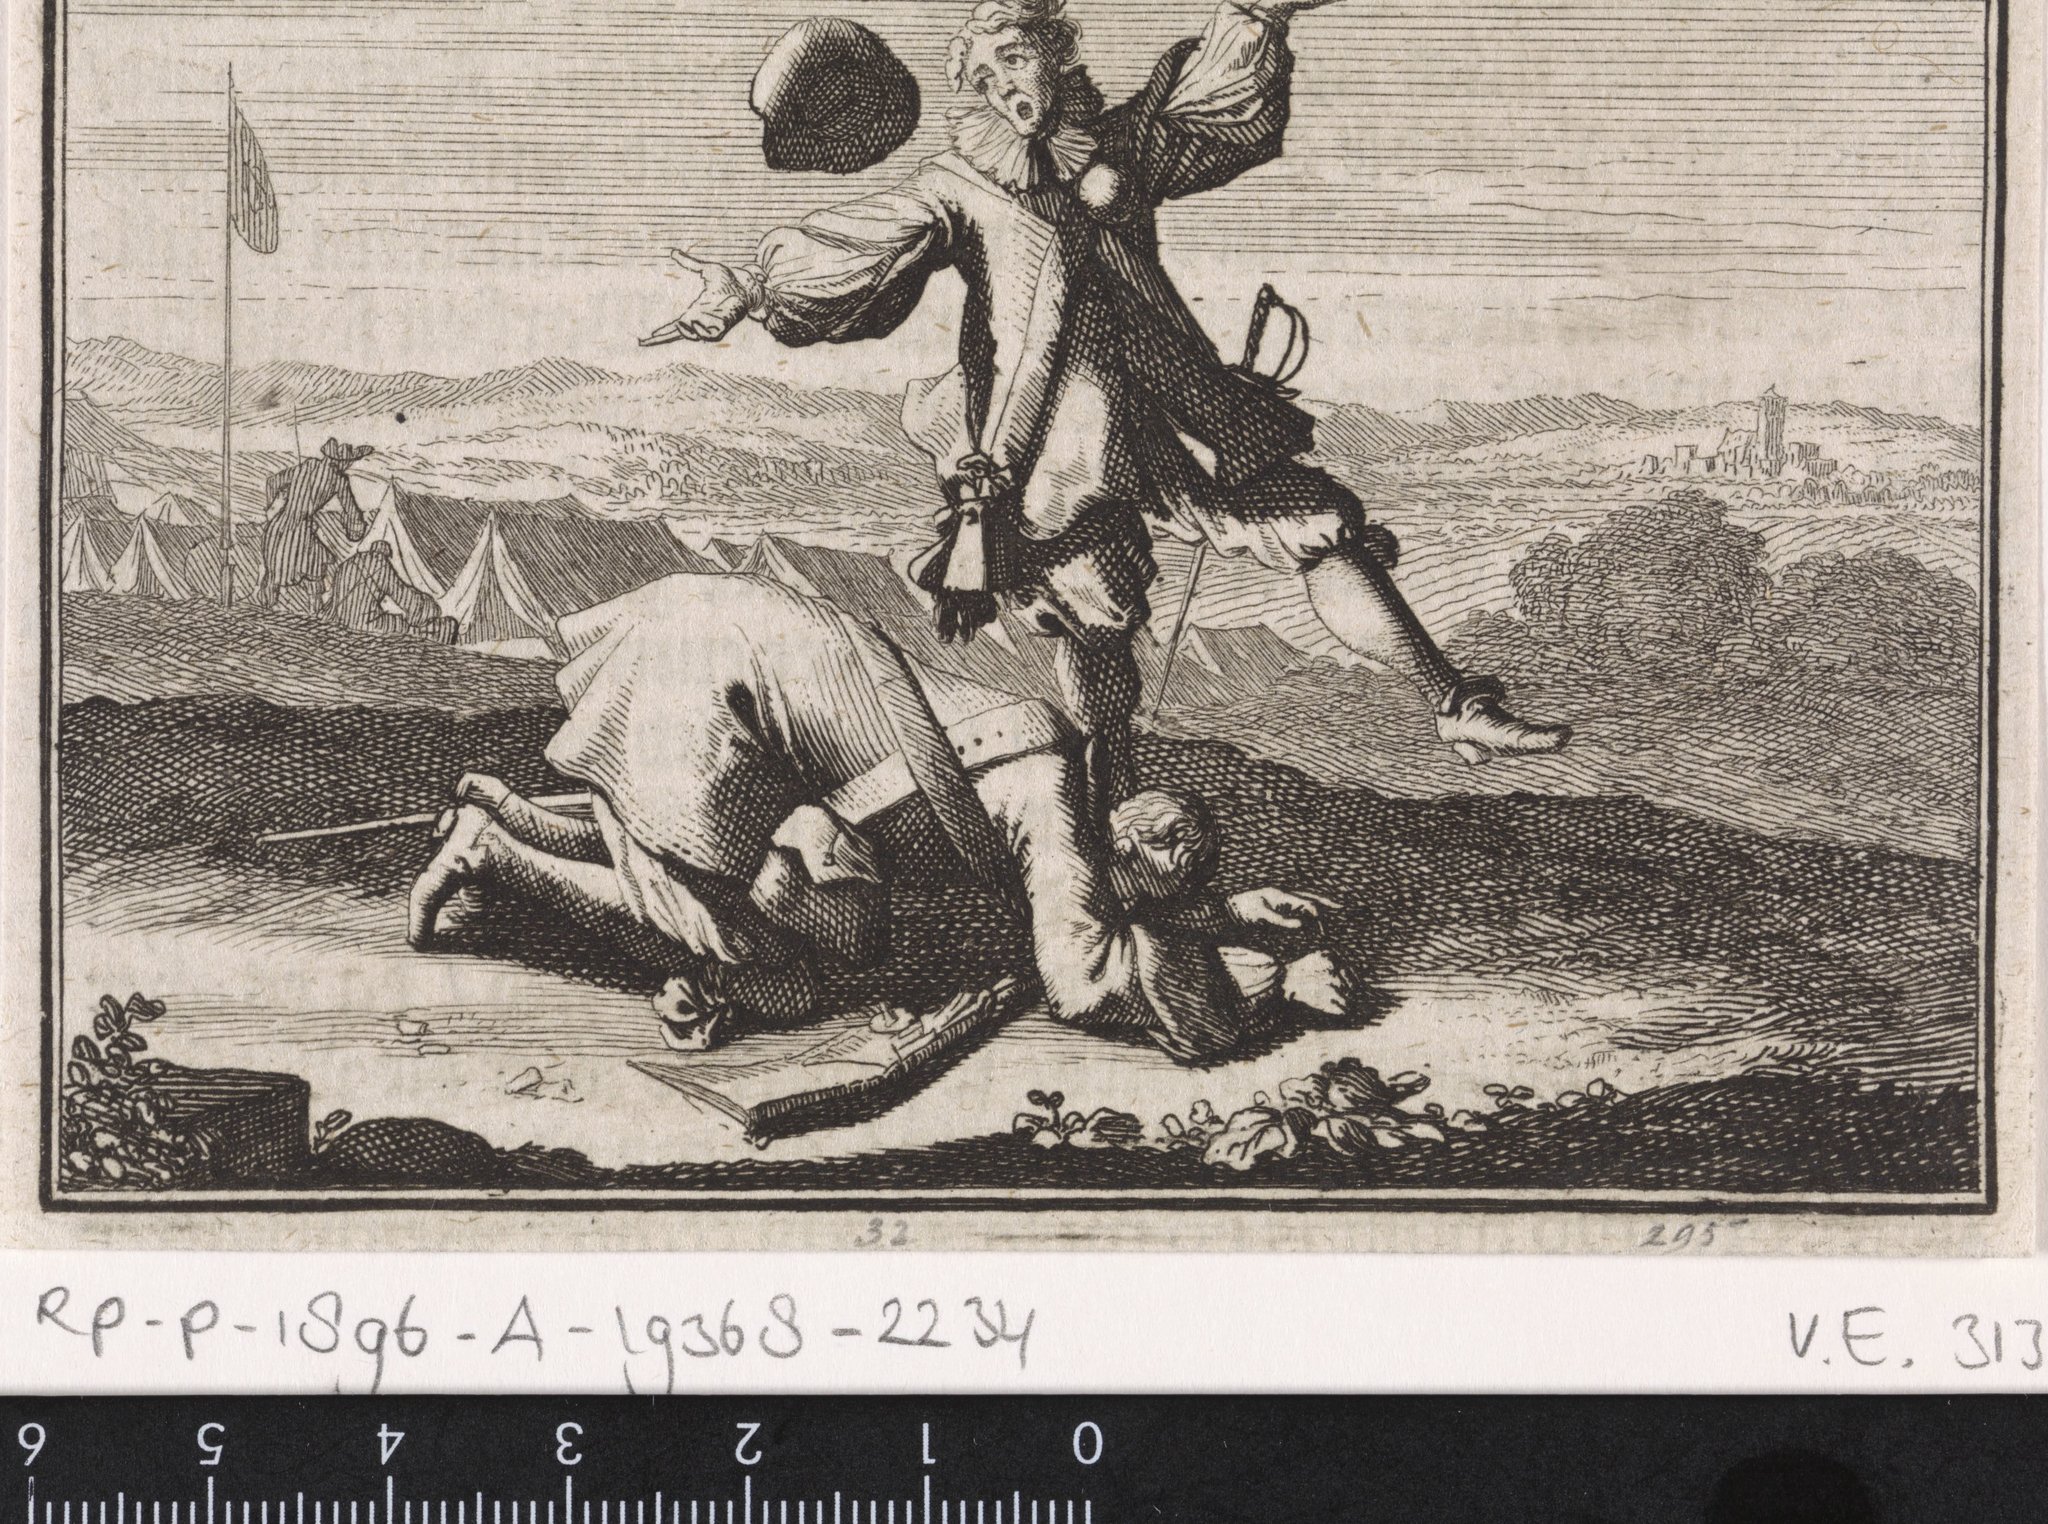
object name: book illustration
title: Keizerlijke soldaat door een kogel getroffen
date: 1704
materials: paper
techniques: etching, letterpress printing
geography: nuremberg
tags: violent death by weapon, private soldier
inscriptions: collector's mark: Lugt 2228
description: Illustratie uit: Abraham a Sancta Clara. Heilsames Gemisch Gemasch, das ist: Allerley seltsame und verwunderliche Geschichten (...). Neurenberg: Christoph Weigel, 1704, p. 295.